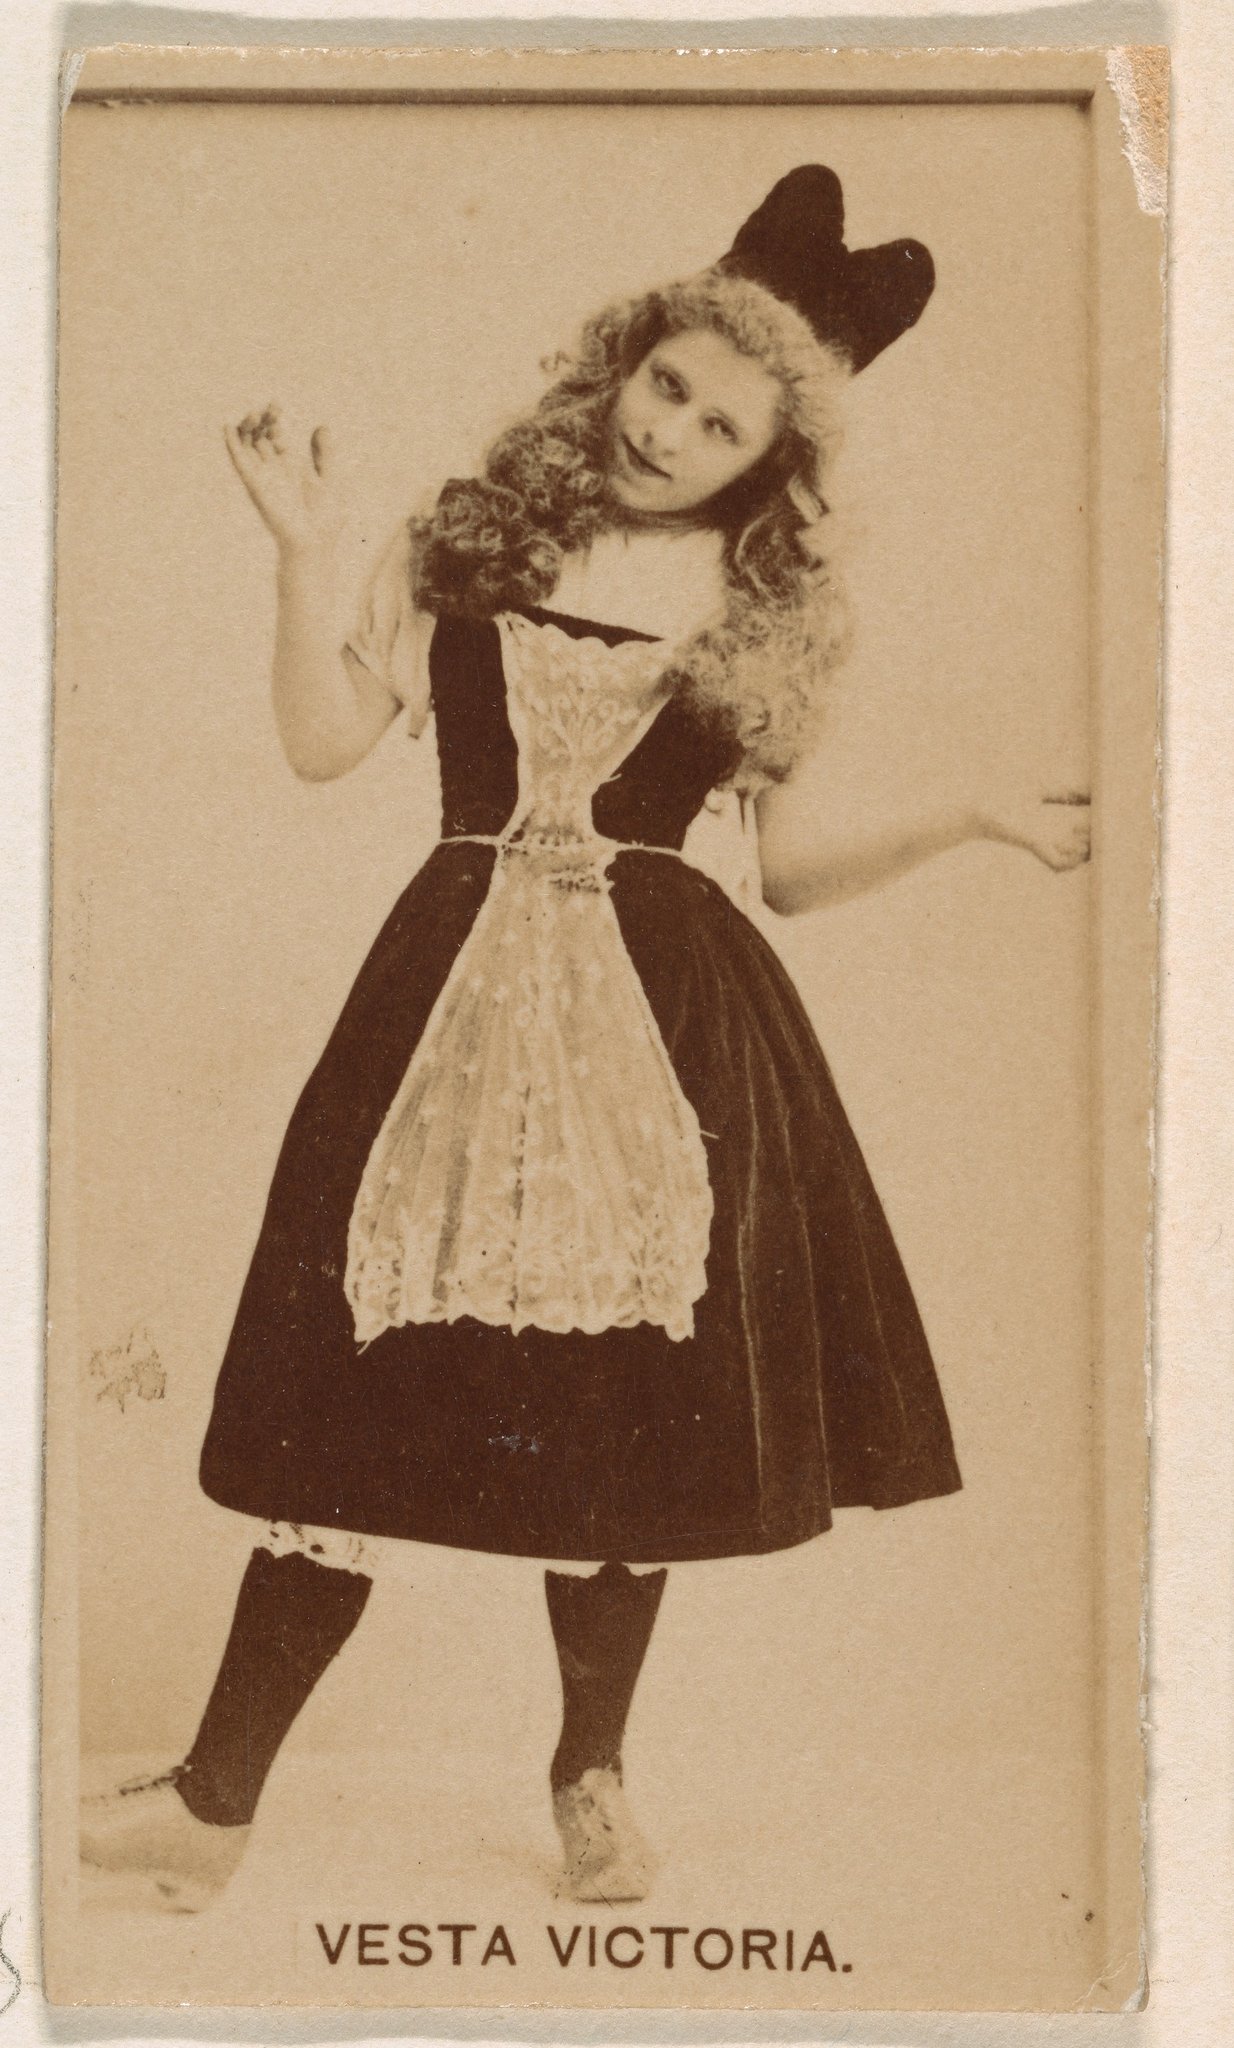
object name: photograph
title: Vesta Victoria, from the Actresses series (N245) issued by Kinney Brothers to promote Sweet Caporal Cigarettes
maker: kinney brothers tobacco company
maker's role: publisher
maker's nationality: american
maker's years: 1869-2011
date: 1890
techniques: albumen silver print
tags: portraits,women,actresses